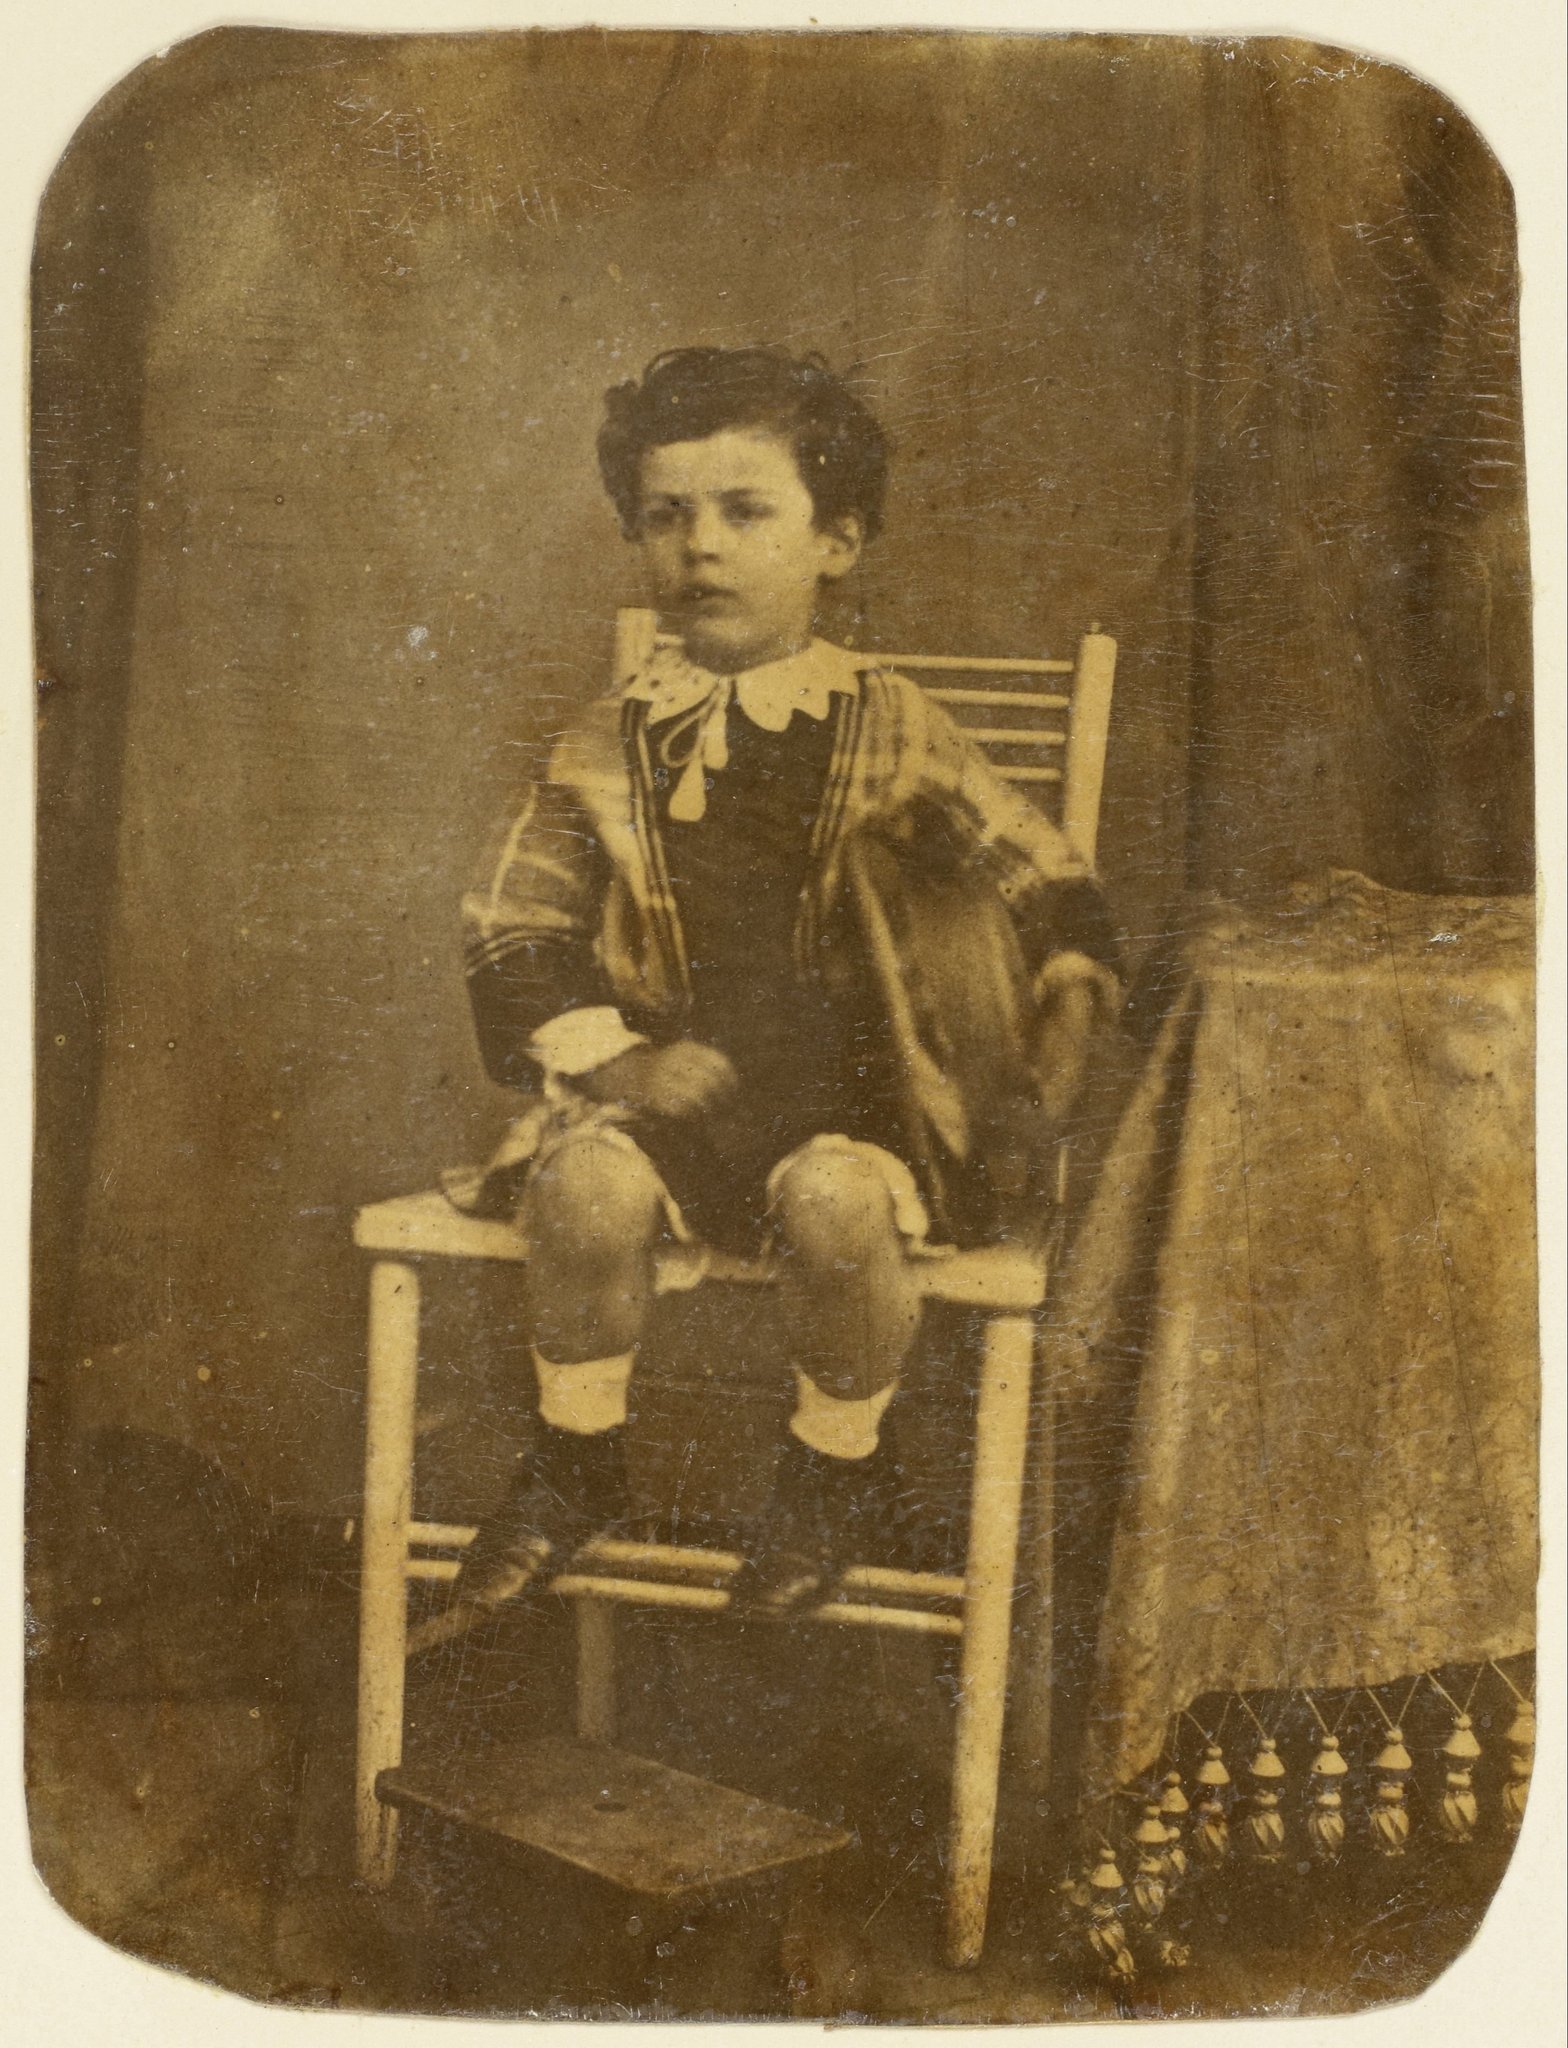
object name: photograph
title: Portret van Lodewijk Asser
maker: eduard isaac asser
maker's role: amateurfotograaf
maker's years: 1809-1894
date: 1854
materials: cardboard, paper, photographic support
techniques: salted paper print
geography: amsterdam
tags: amsterdam, historical persons